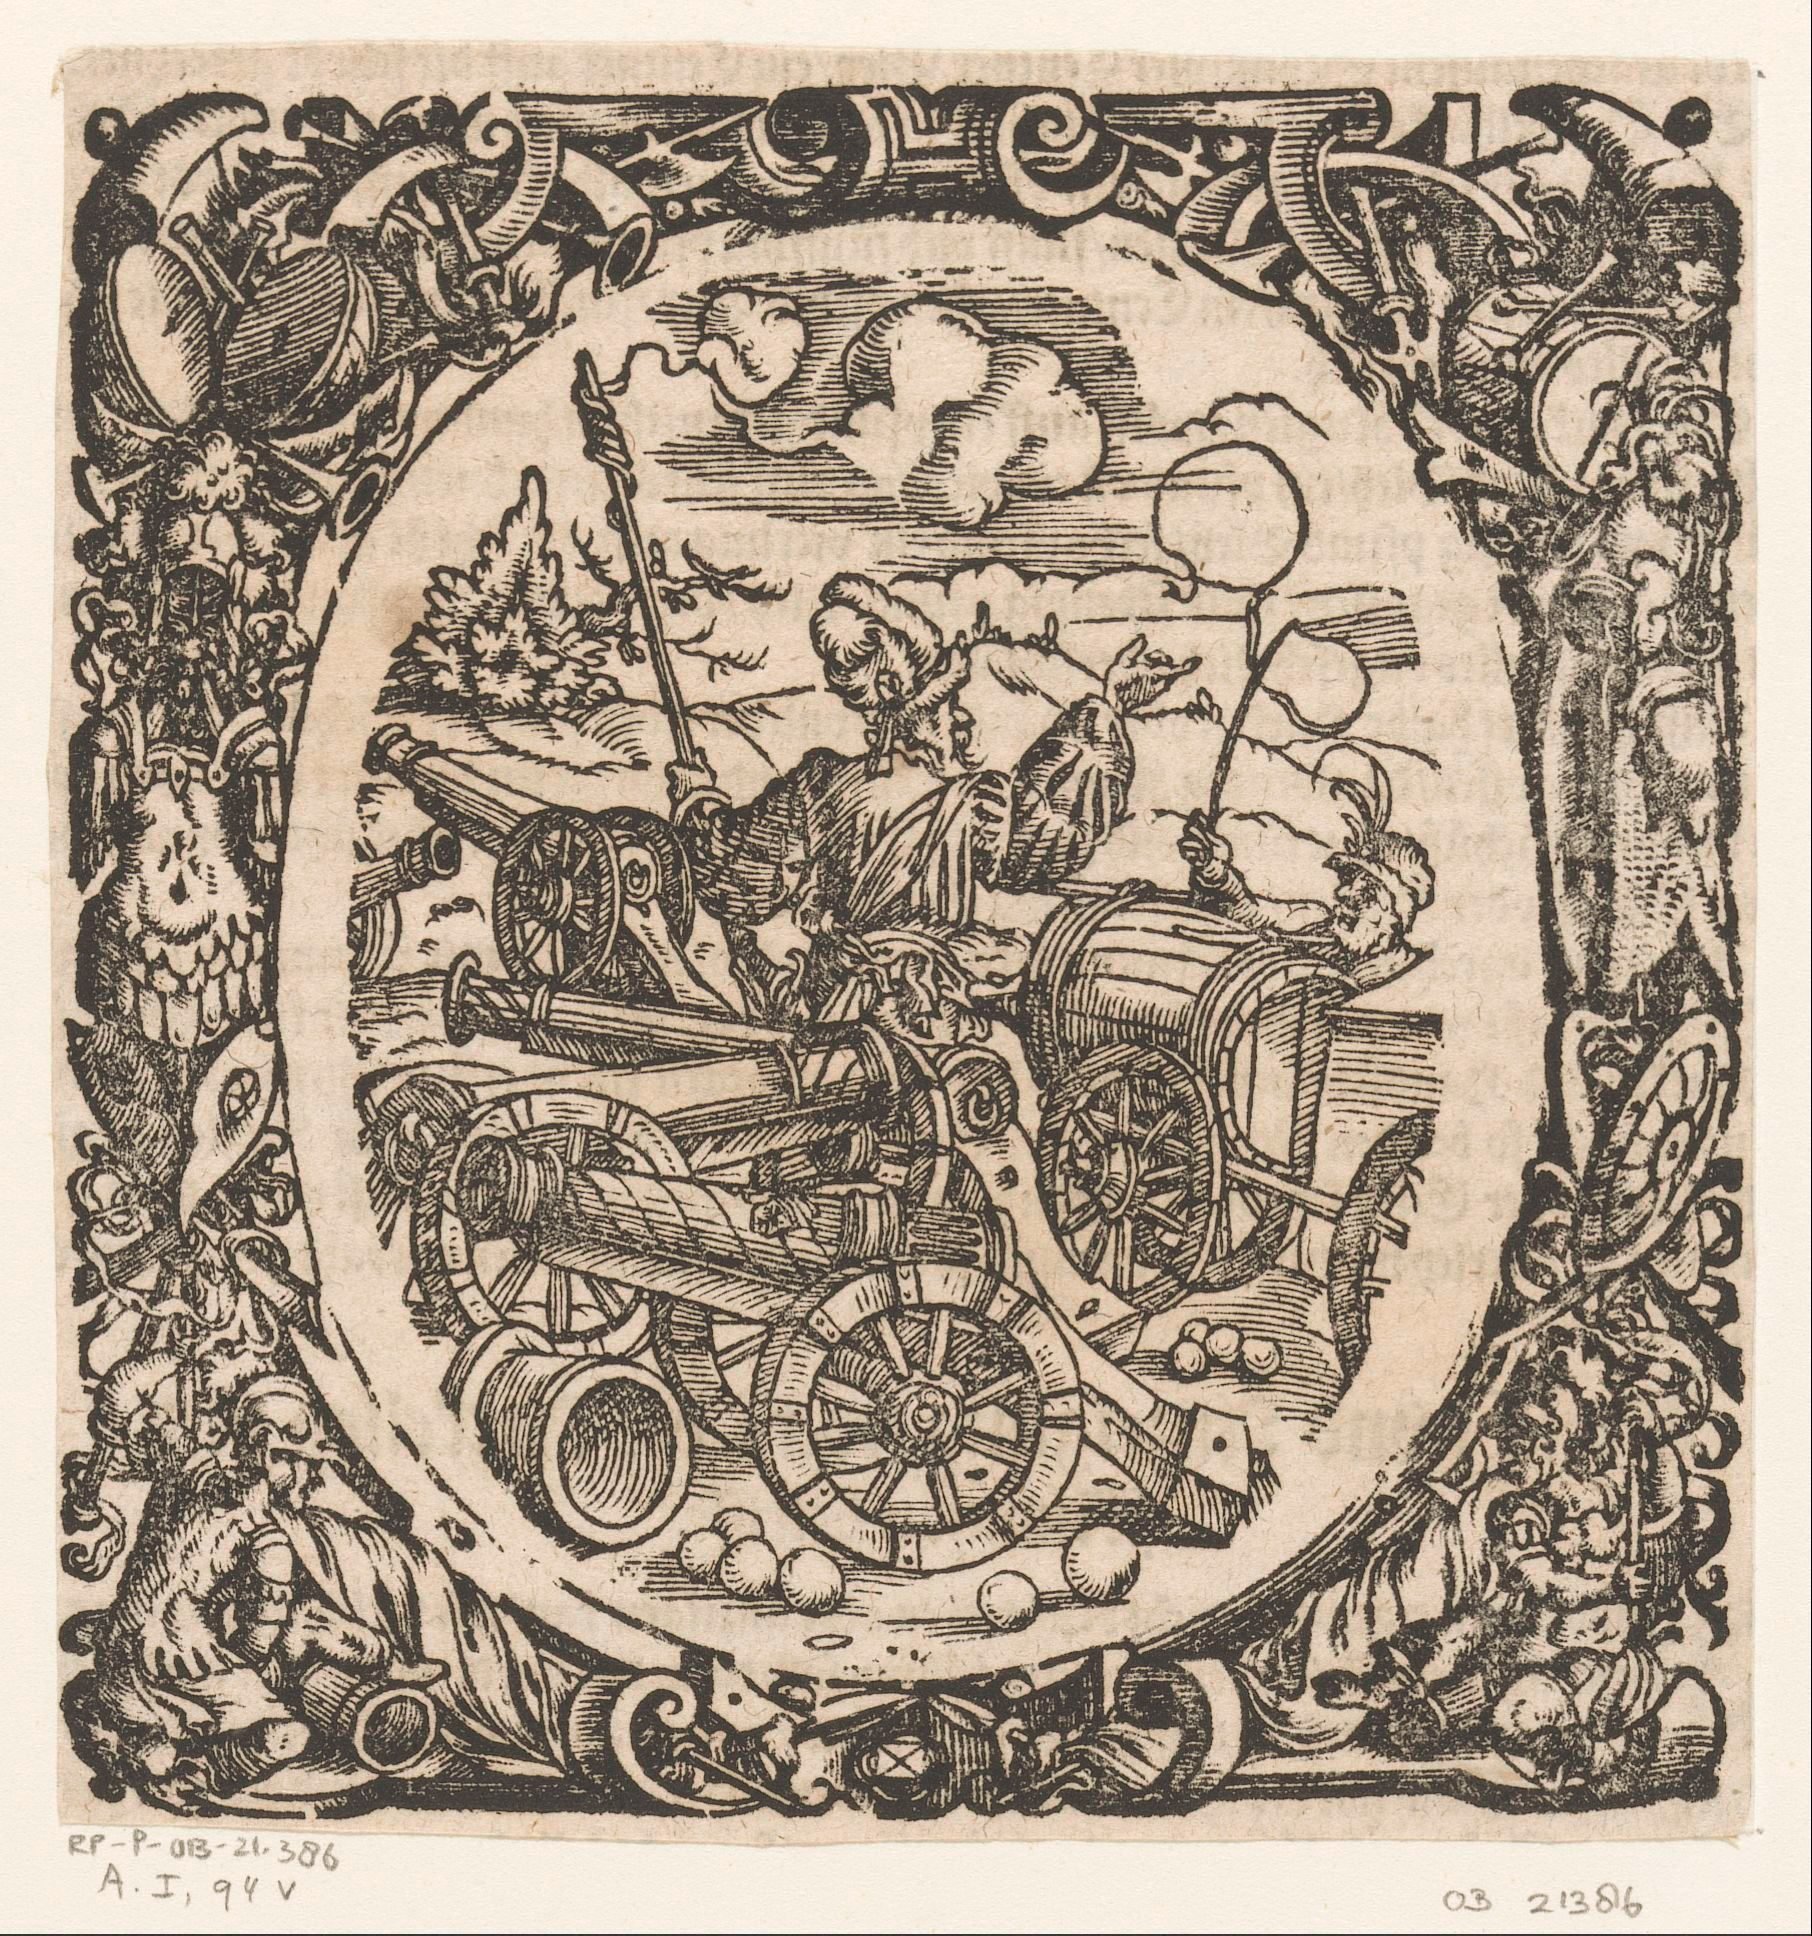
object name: book illustration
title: Kanonnier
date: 1573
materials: paper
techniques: woodcut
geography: nuremberg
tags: firearms: cannon, warfare; military affairs, the soldier; the soldier's life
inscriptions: collector's mark: Lugt 240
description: Zowel de voorstelling als de ornamentrand werd gebruikt voor verschillende edities van Leonhardt Fronspergers Kriegsbuch.